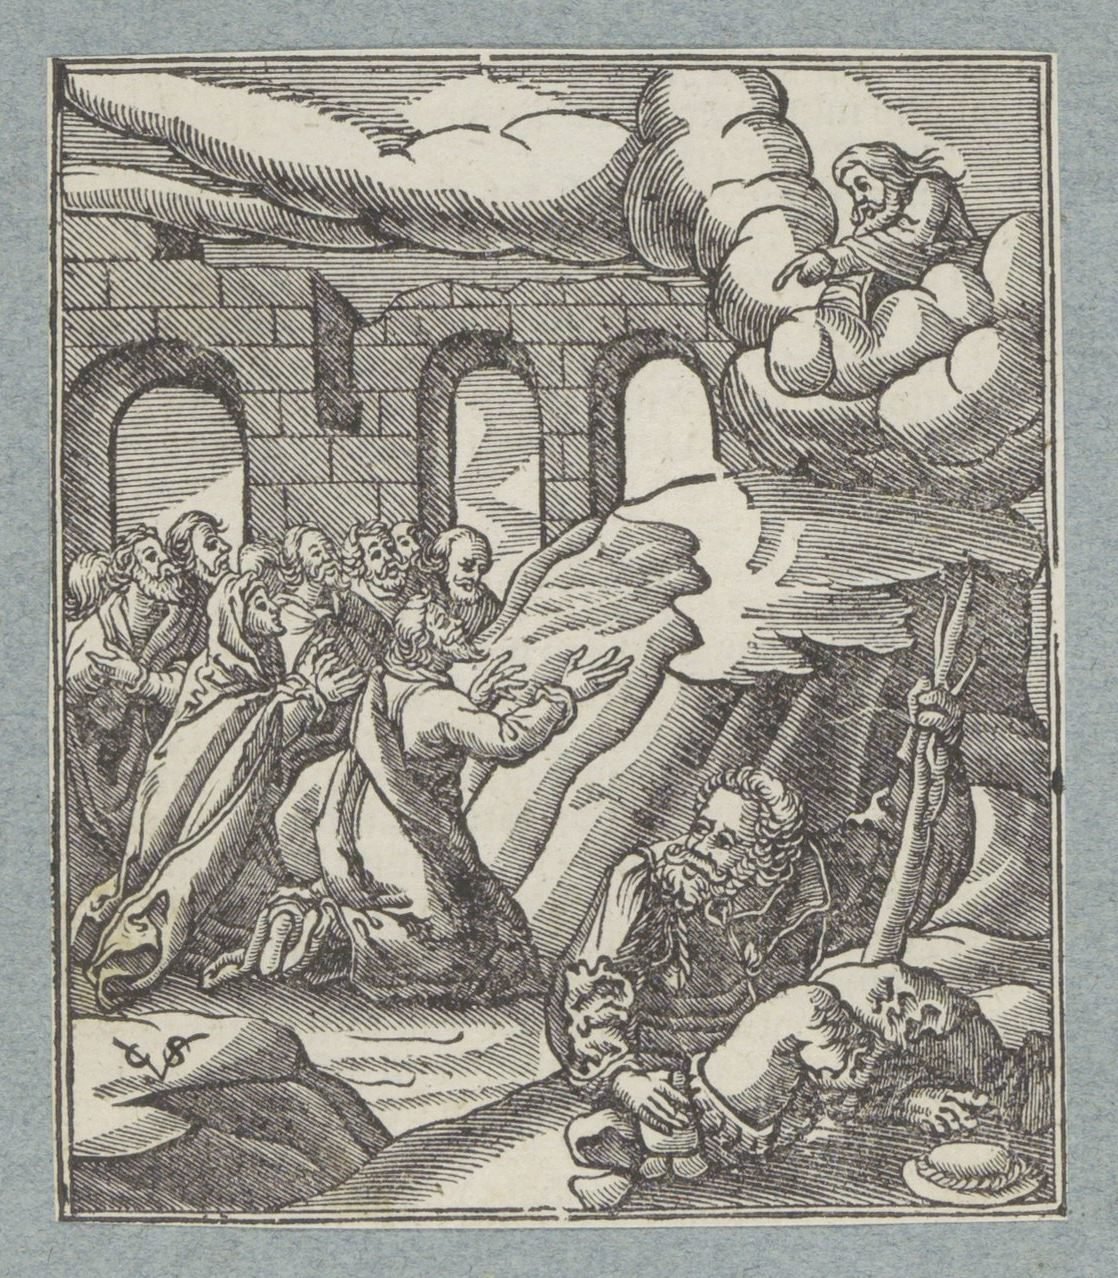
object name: print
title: Hulpgeroep van Israëlieten gehoord door God de Vader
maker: pieter jacobsz. paets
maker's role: publisher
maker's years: 1587-1667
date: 1645-1646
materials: paper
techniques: letterpress printing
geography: amsterdam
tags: god looking upon the israelites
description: De prent werd gemaakt voor de uitgaven van P.J. Paets uit Amsterdam. Ze komt in ieder geval voor in: Bibels Tresoor ofte der zielen lusthof. Amsterdam, P.J. Paets, 1646. Mogelijk ook in: Historien ende Prophetien. [Amsterdam], P.J. Paets, 1645.